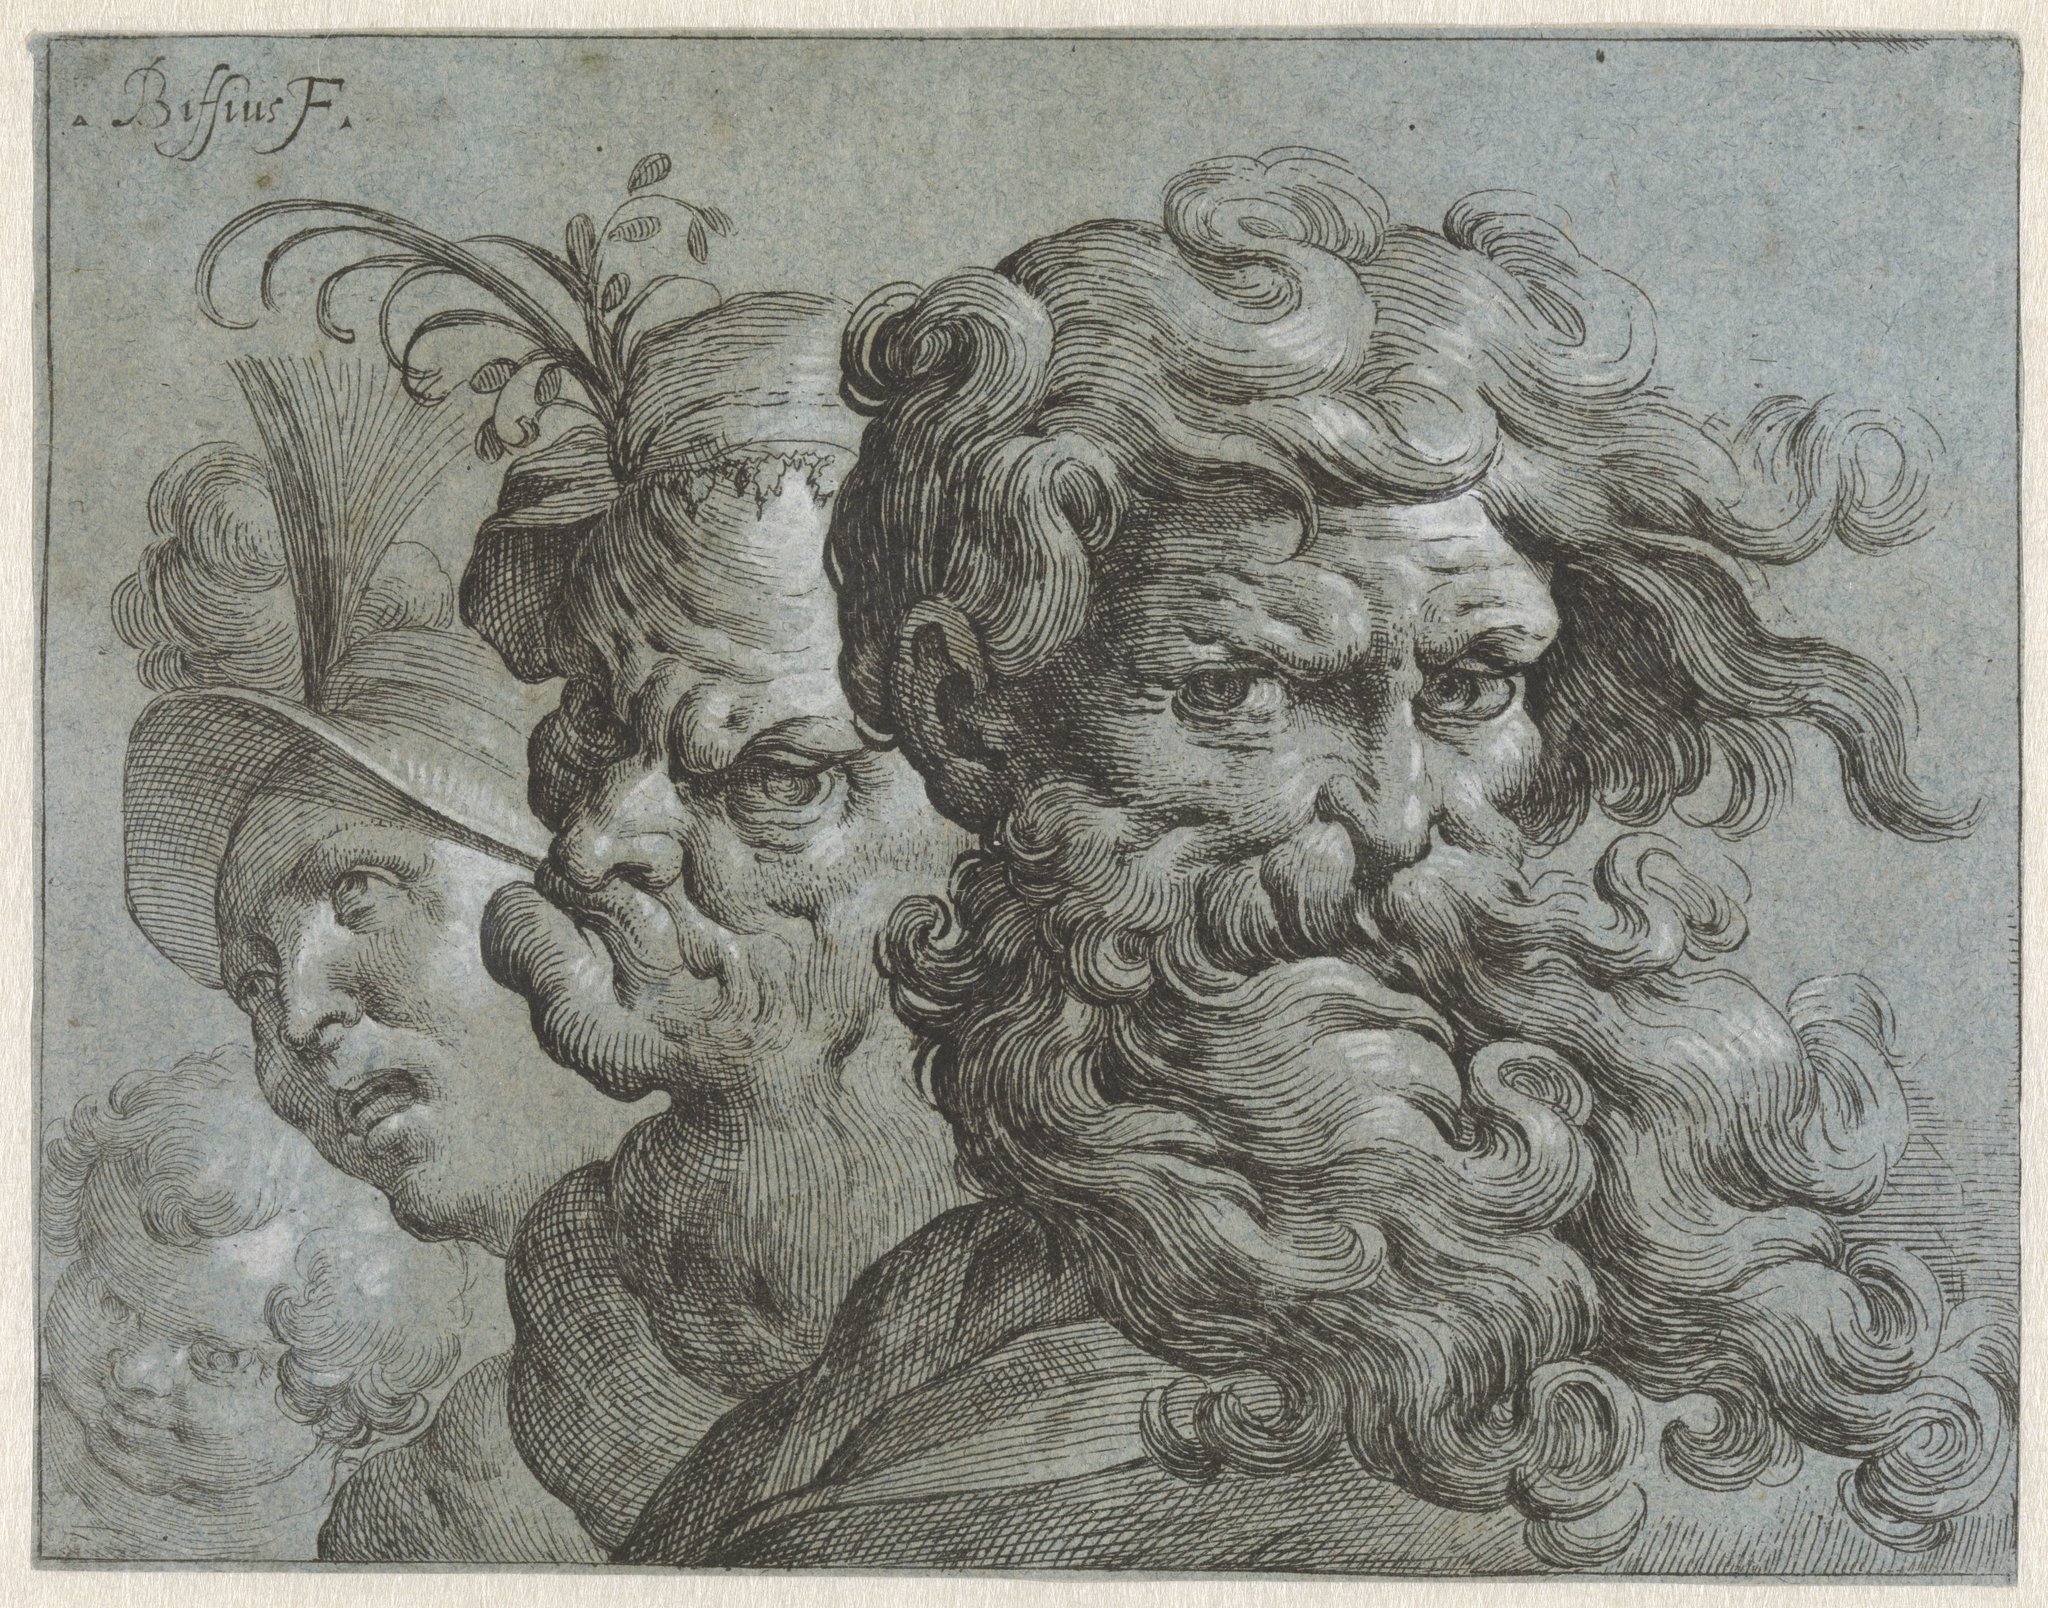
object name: print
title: Four Character Heads of Boys and Men of Different Ages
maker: carlo biffi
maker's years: 1605-1675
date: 1635-1650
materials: paper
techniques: etching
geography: italy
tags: the ages of man, characters (human types)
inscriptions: collector's mark: Lugt 2760, collector's mark: Lugt 2228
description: Carlo Biffi was actually trained as a sculptor. However, this etching – one of only two that we know by him – bears witness to his graphic talent. The four heads are printed on blue paper, and heightened with white to increase the plasticity of the image. The effect of depth is enhanced by the fact that the heads were etched from front to back with ever thinner lines.